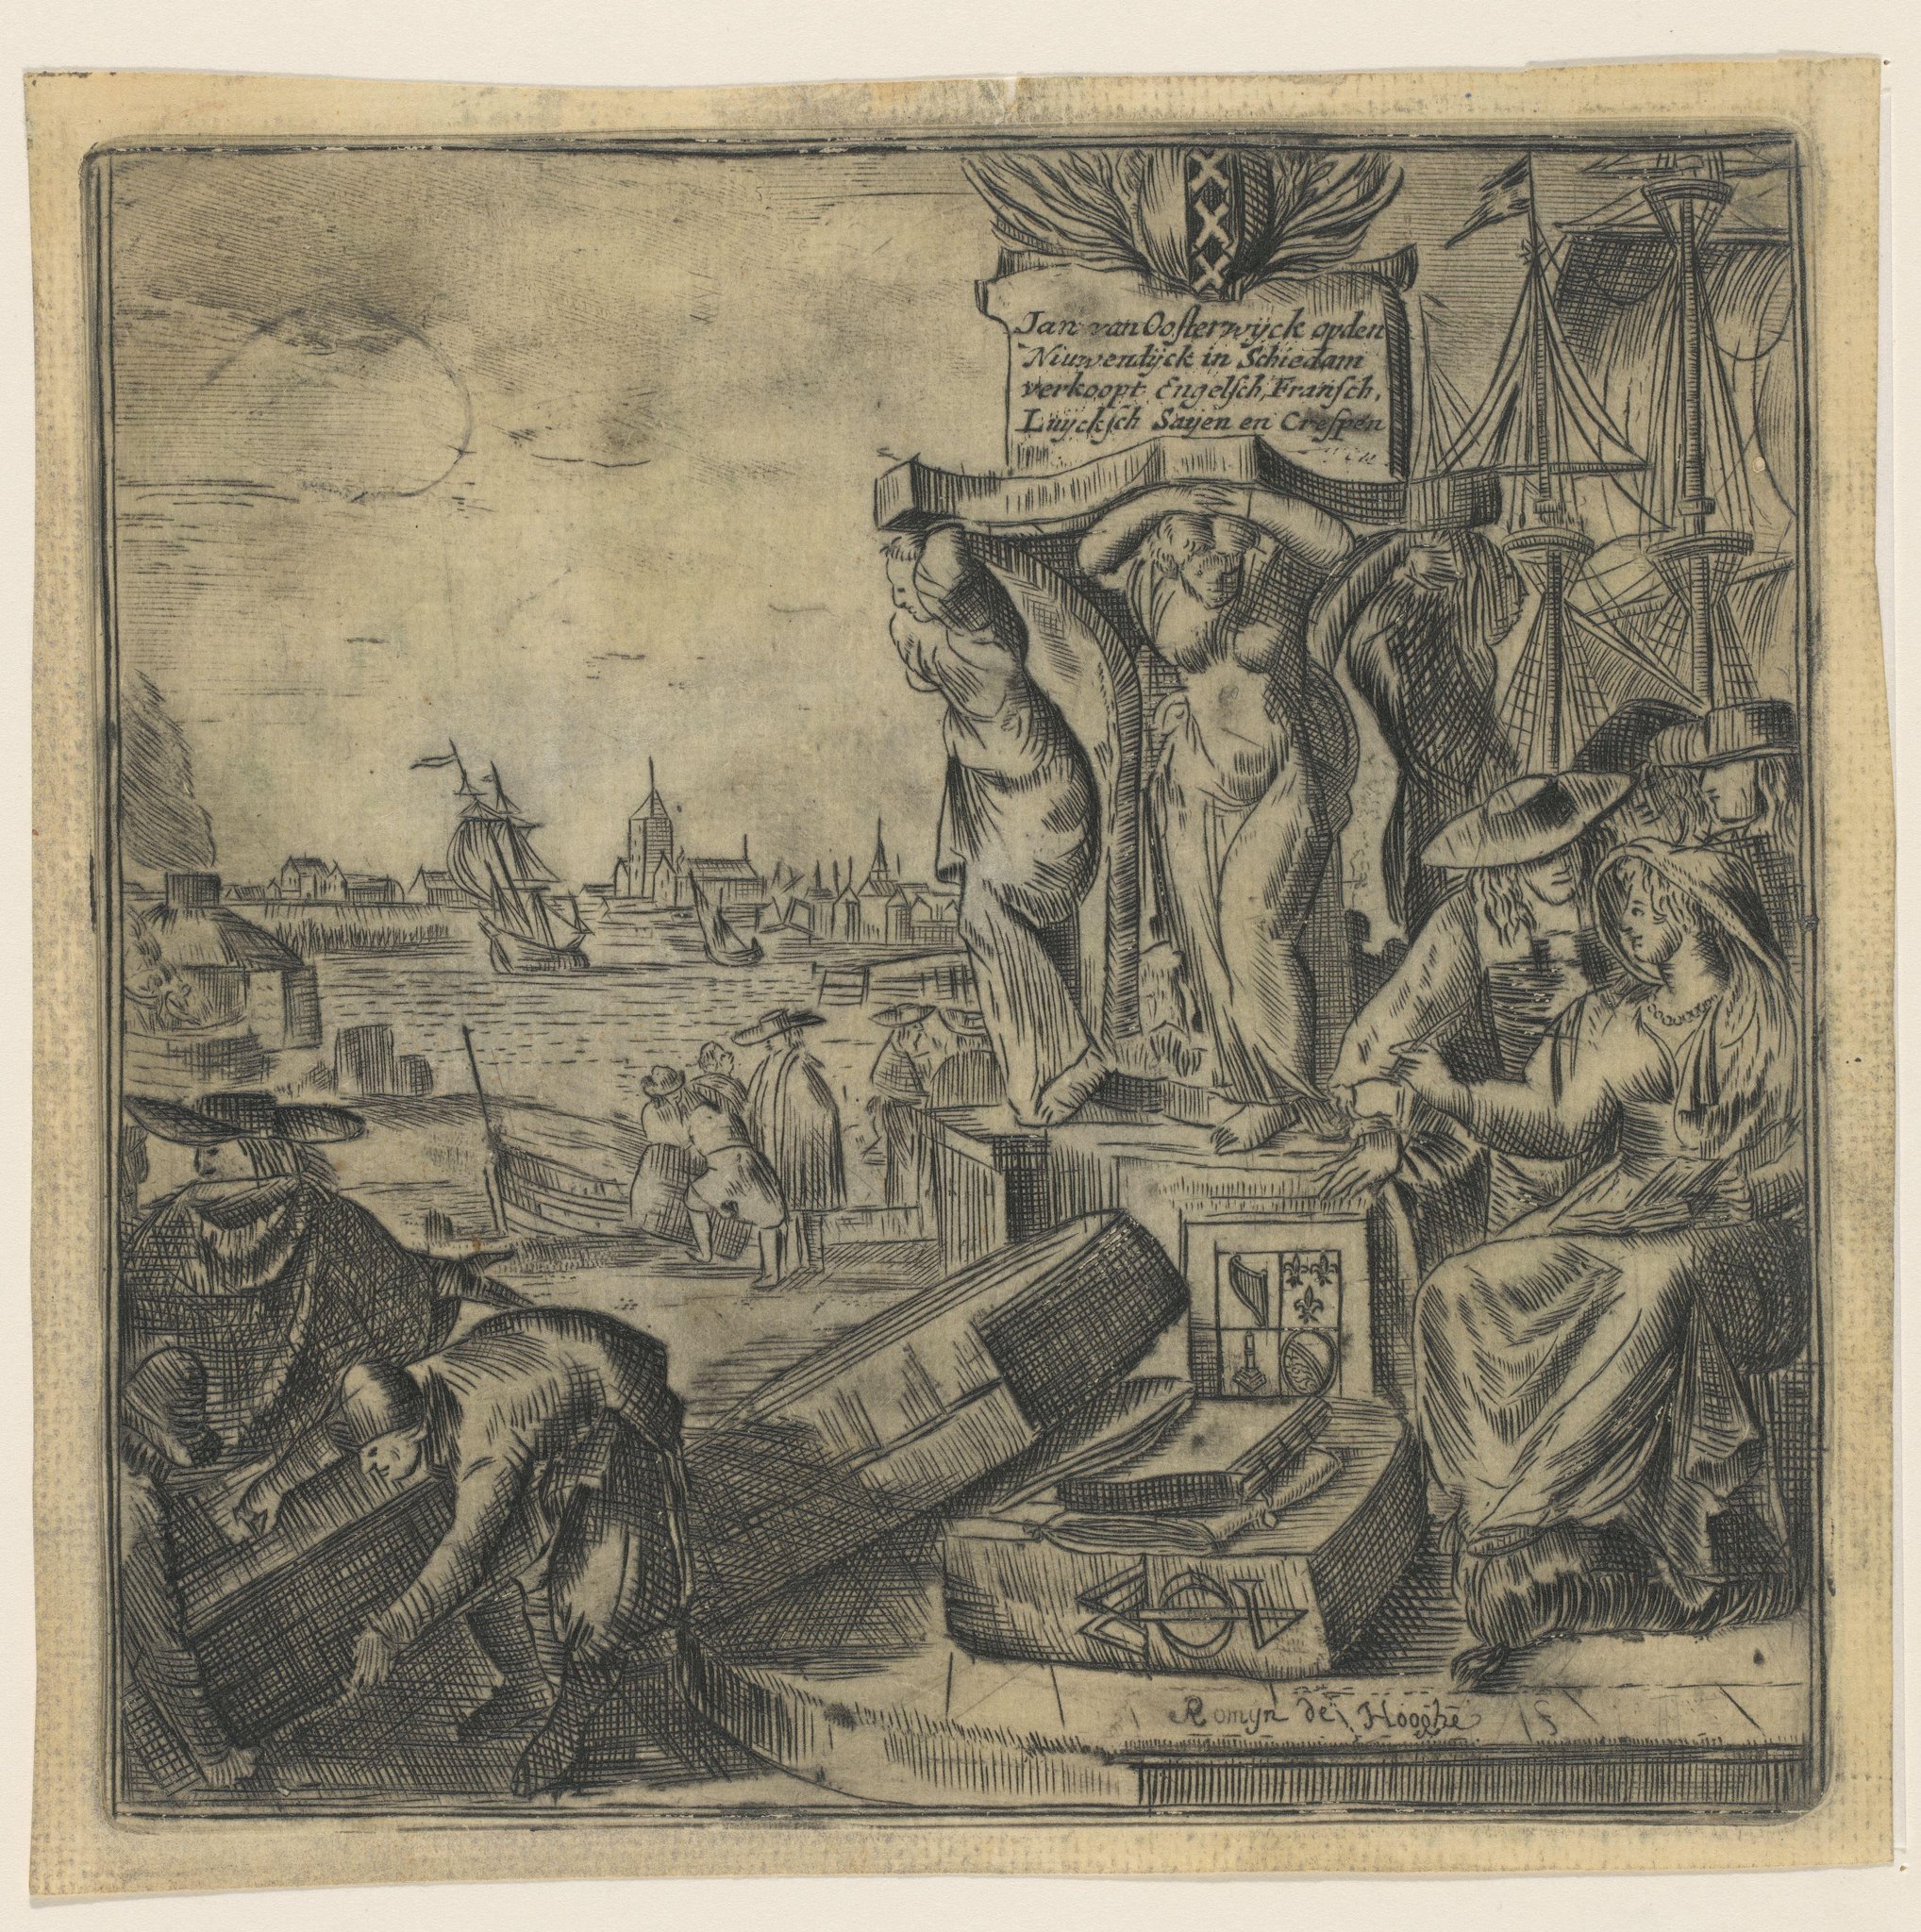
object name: print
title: Reclameprent (tradecard) van de stoffenhandelaar Jan van Oosterwijck, in het huis Schiedam op de Nieuwedijk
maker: romeyn de hooghe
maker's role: draughtsman, goldsmith, painter, print maker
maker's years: 1645-1708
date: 1674-1682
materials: paper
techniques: engraving, etching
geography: amsterdam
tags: harbour, caryatids ~ architecture, merchant shipping, shipping trade, trade mark, trade token, trade sign, trade card, wool (material ~ textile industry), silk (material ~ textile industry), amsterdam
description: Op de voorgrond balen stof, waarmee twee mannen in de weer zijn. Rechts zit een vrouw met een boek op schoot (wellicht een stalenboek), met daarachter een drietal mannen en scheepsmasten. In het midden dragen drie kariatiden een platform met daarop het wapen van Amsterdam en een plaquette met de tekst: 'Jan van Oosterwijck opden Nieuwendijck in Schiedam verkoopt Engelsch Fransch Luijcksch saijen en crespen.'